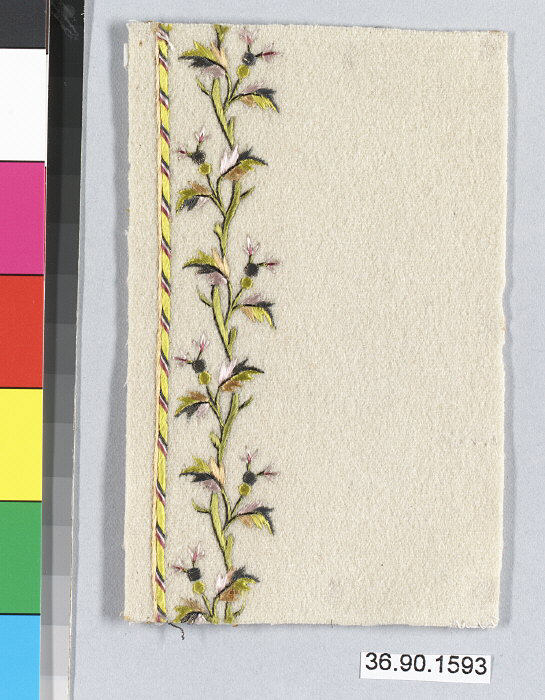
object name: sample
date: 1801-1833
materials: felt, metal thread, silk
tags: flowers